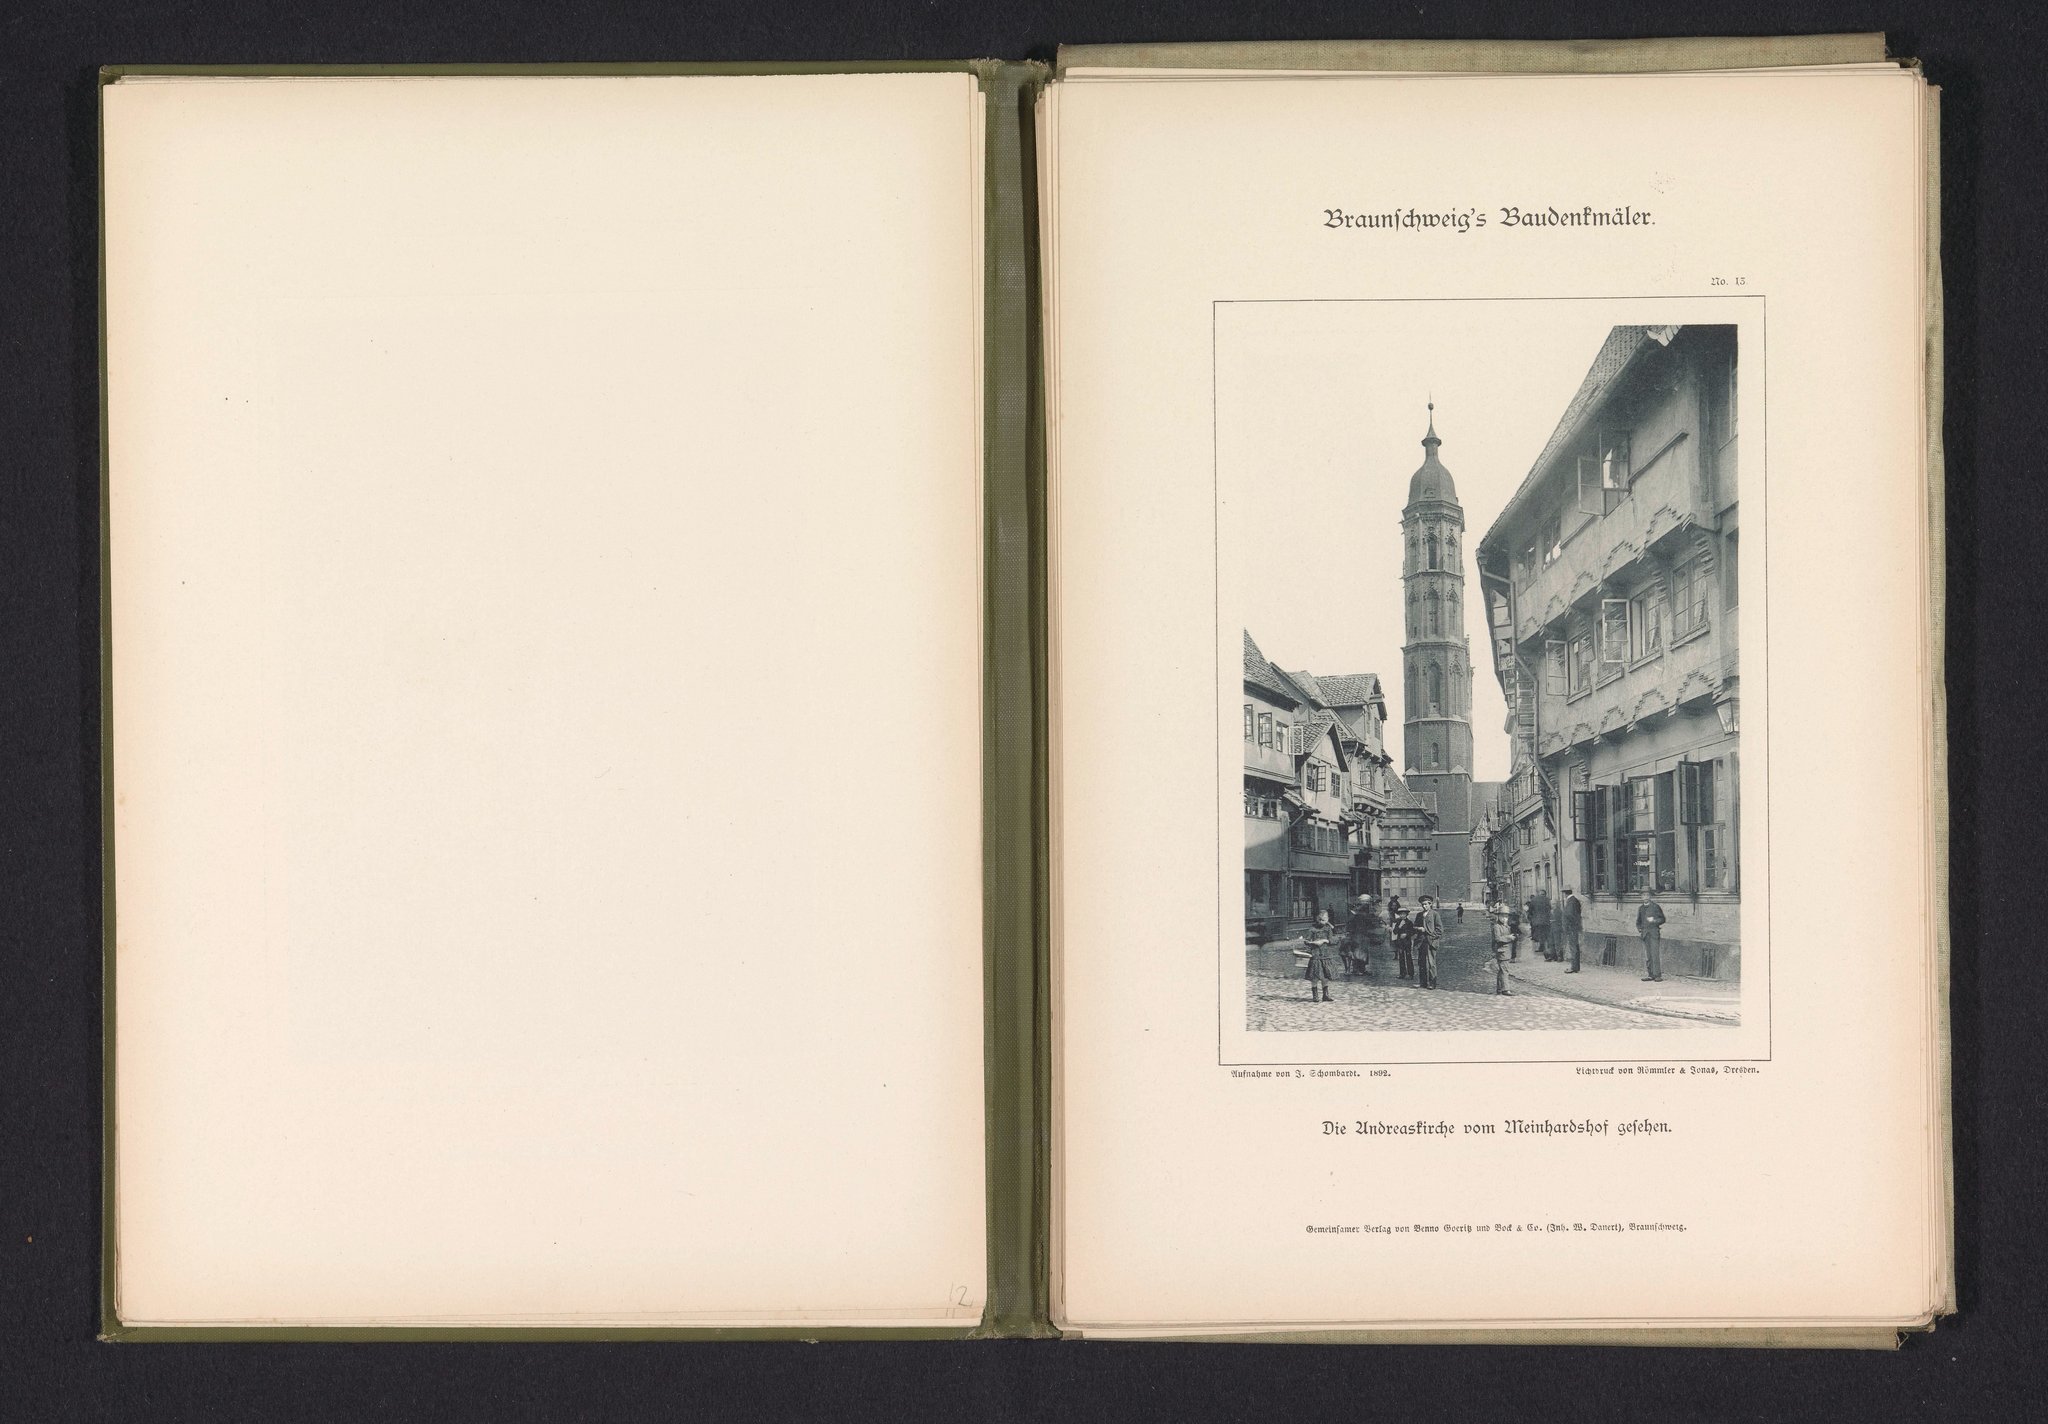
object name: photomechanical print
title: Die Andreaskirche vom Meinhardshof gesehen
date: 1892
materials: paper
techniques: photograph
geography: braunschweig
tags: church (exterior)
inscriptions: number: ‘No. 13.’